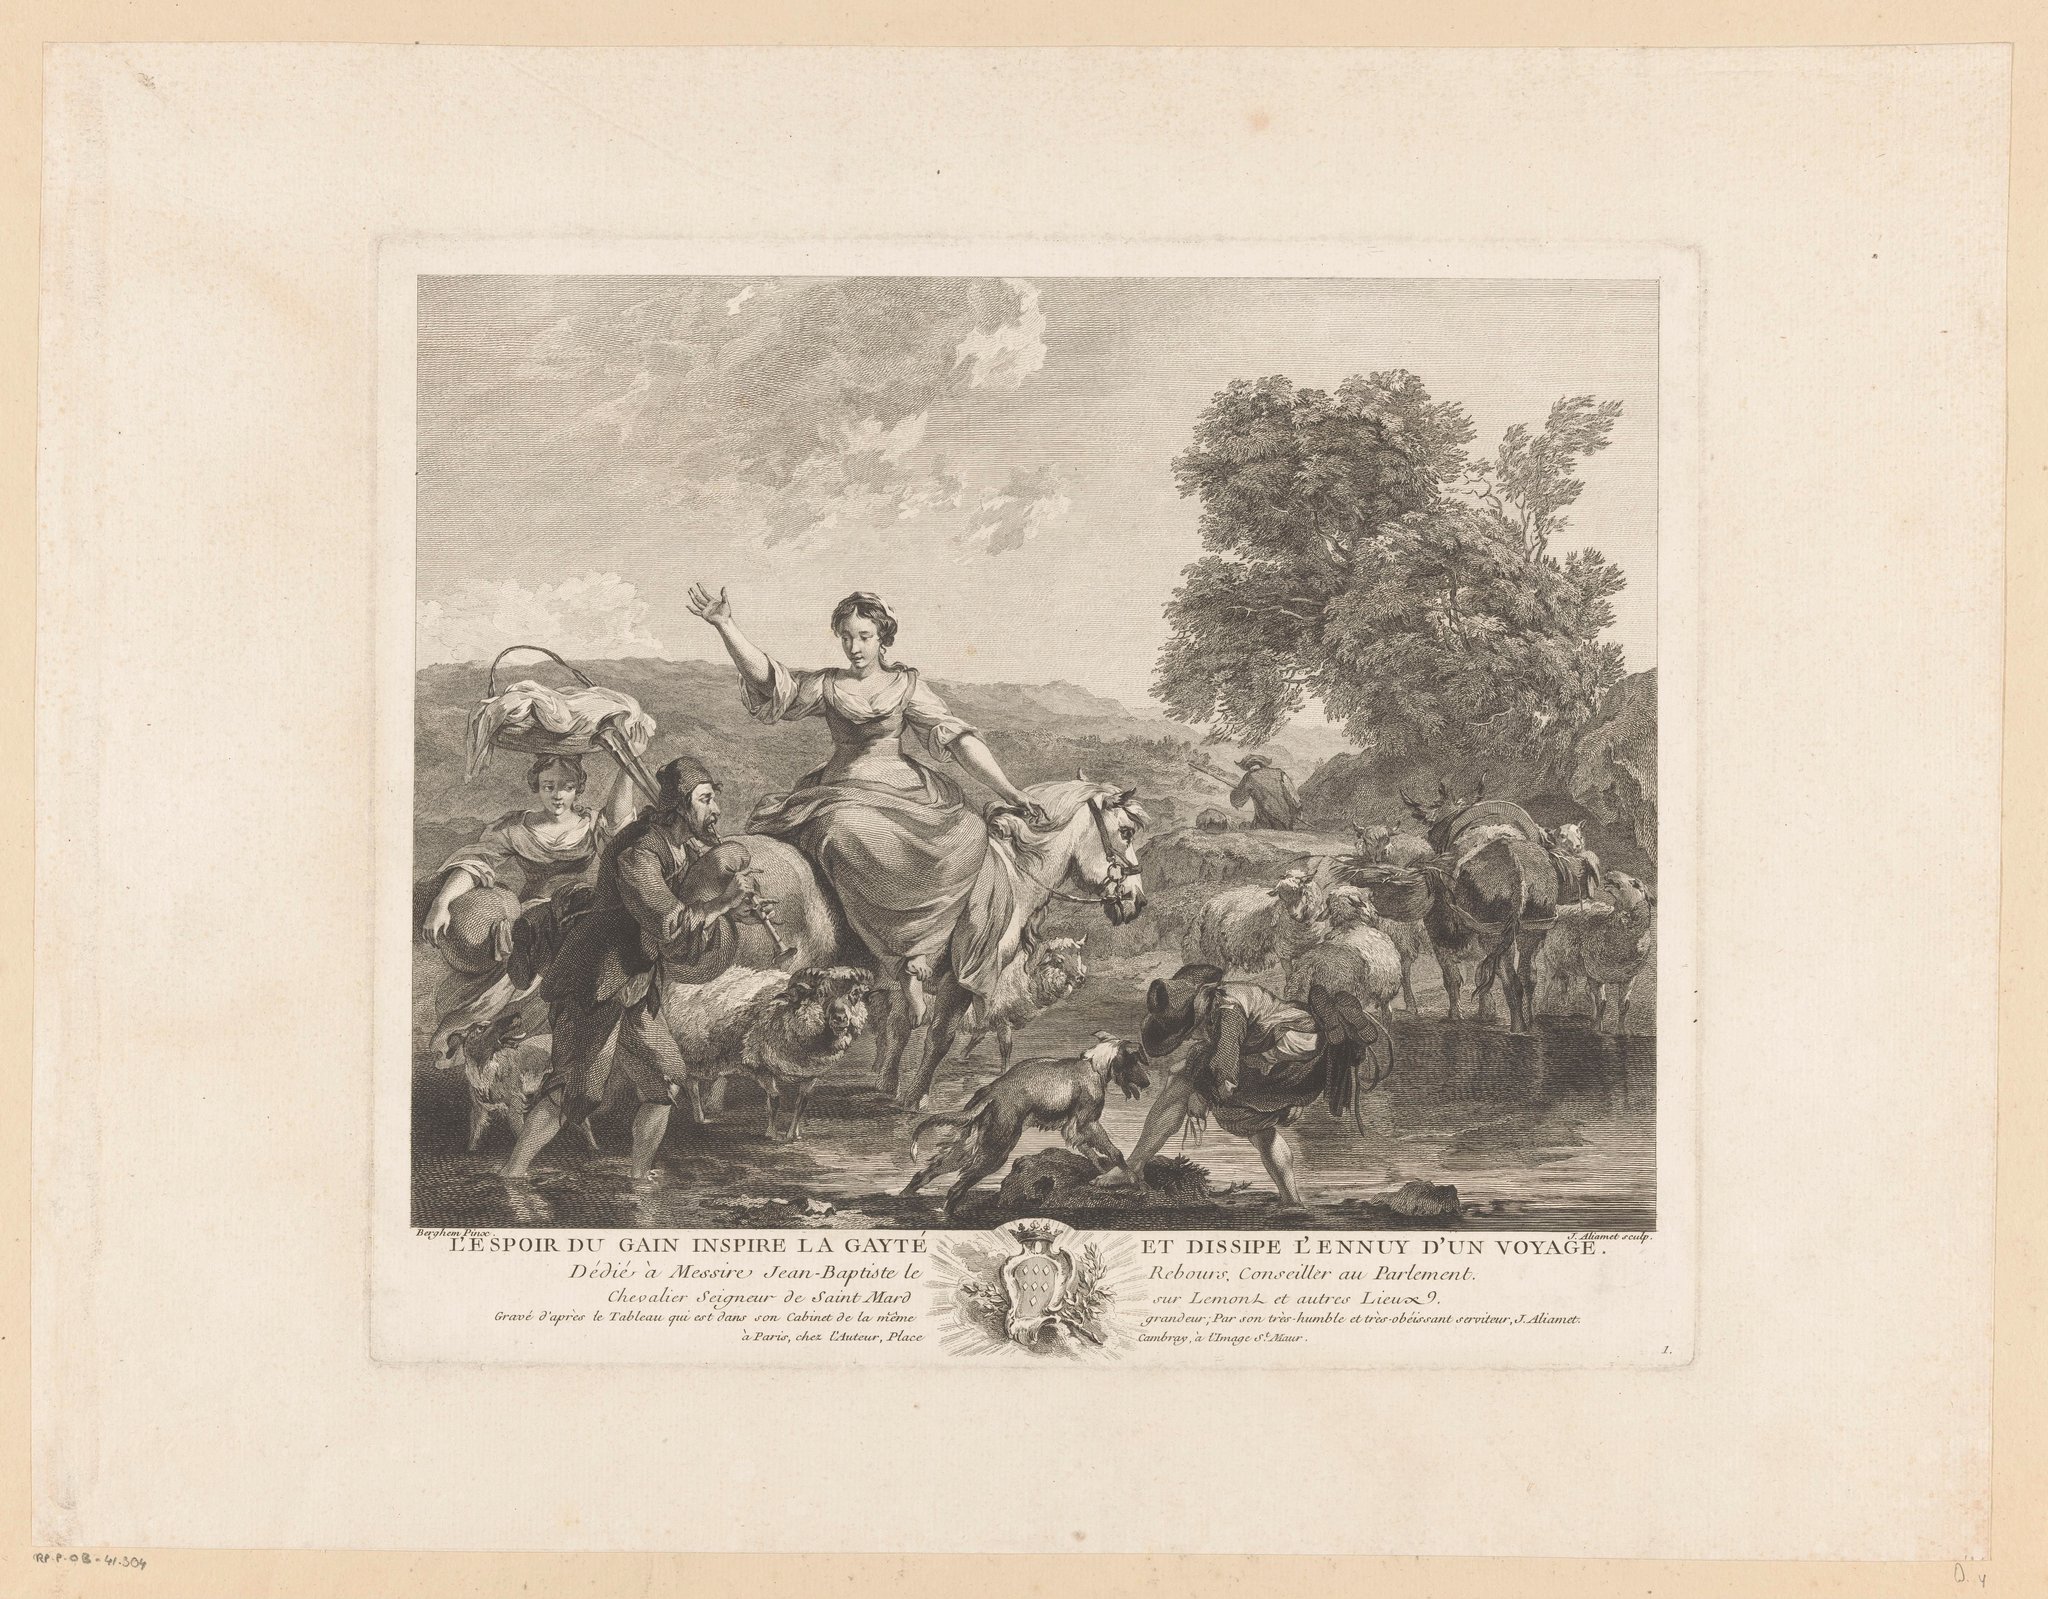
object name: print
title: Reizigers bij een bron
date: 1750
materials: paper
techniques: engraving, etching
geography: netherlands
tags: landscapes, bagpipe, musette - cc - out of doors, 'en route', traveller under way, herd, flock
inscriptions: collector's mark: Lugt 240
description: De ets werd in 1750 gepubliceerd als serie van vier prenten naar schilderijen van zeventiende-eeuwse Nederlandse meesters in Frans bezit (zie ook RP-P-OB-41.301).